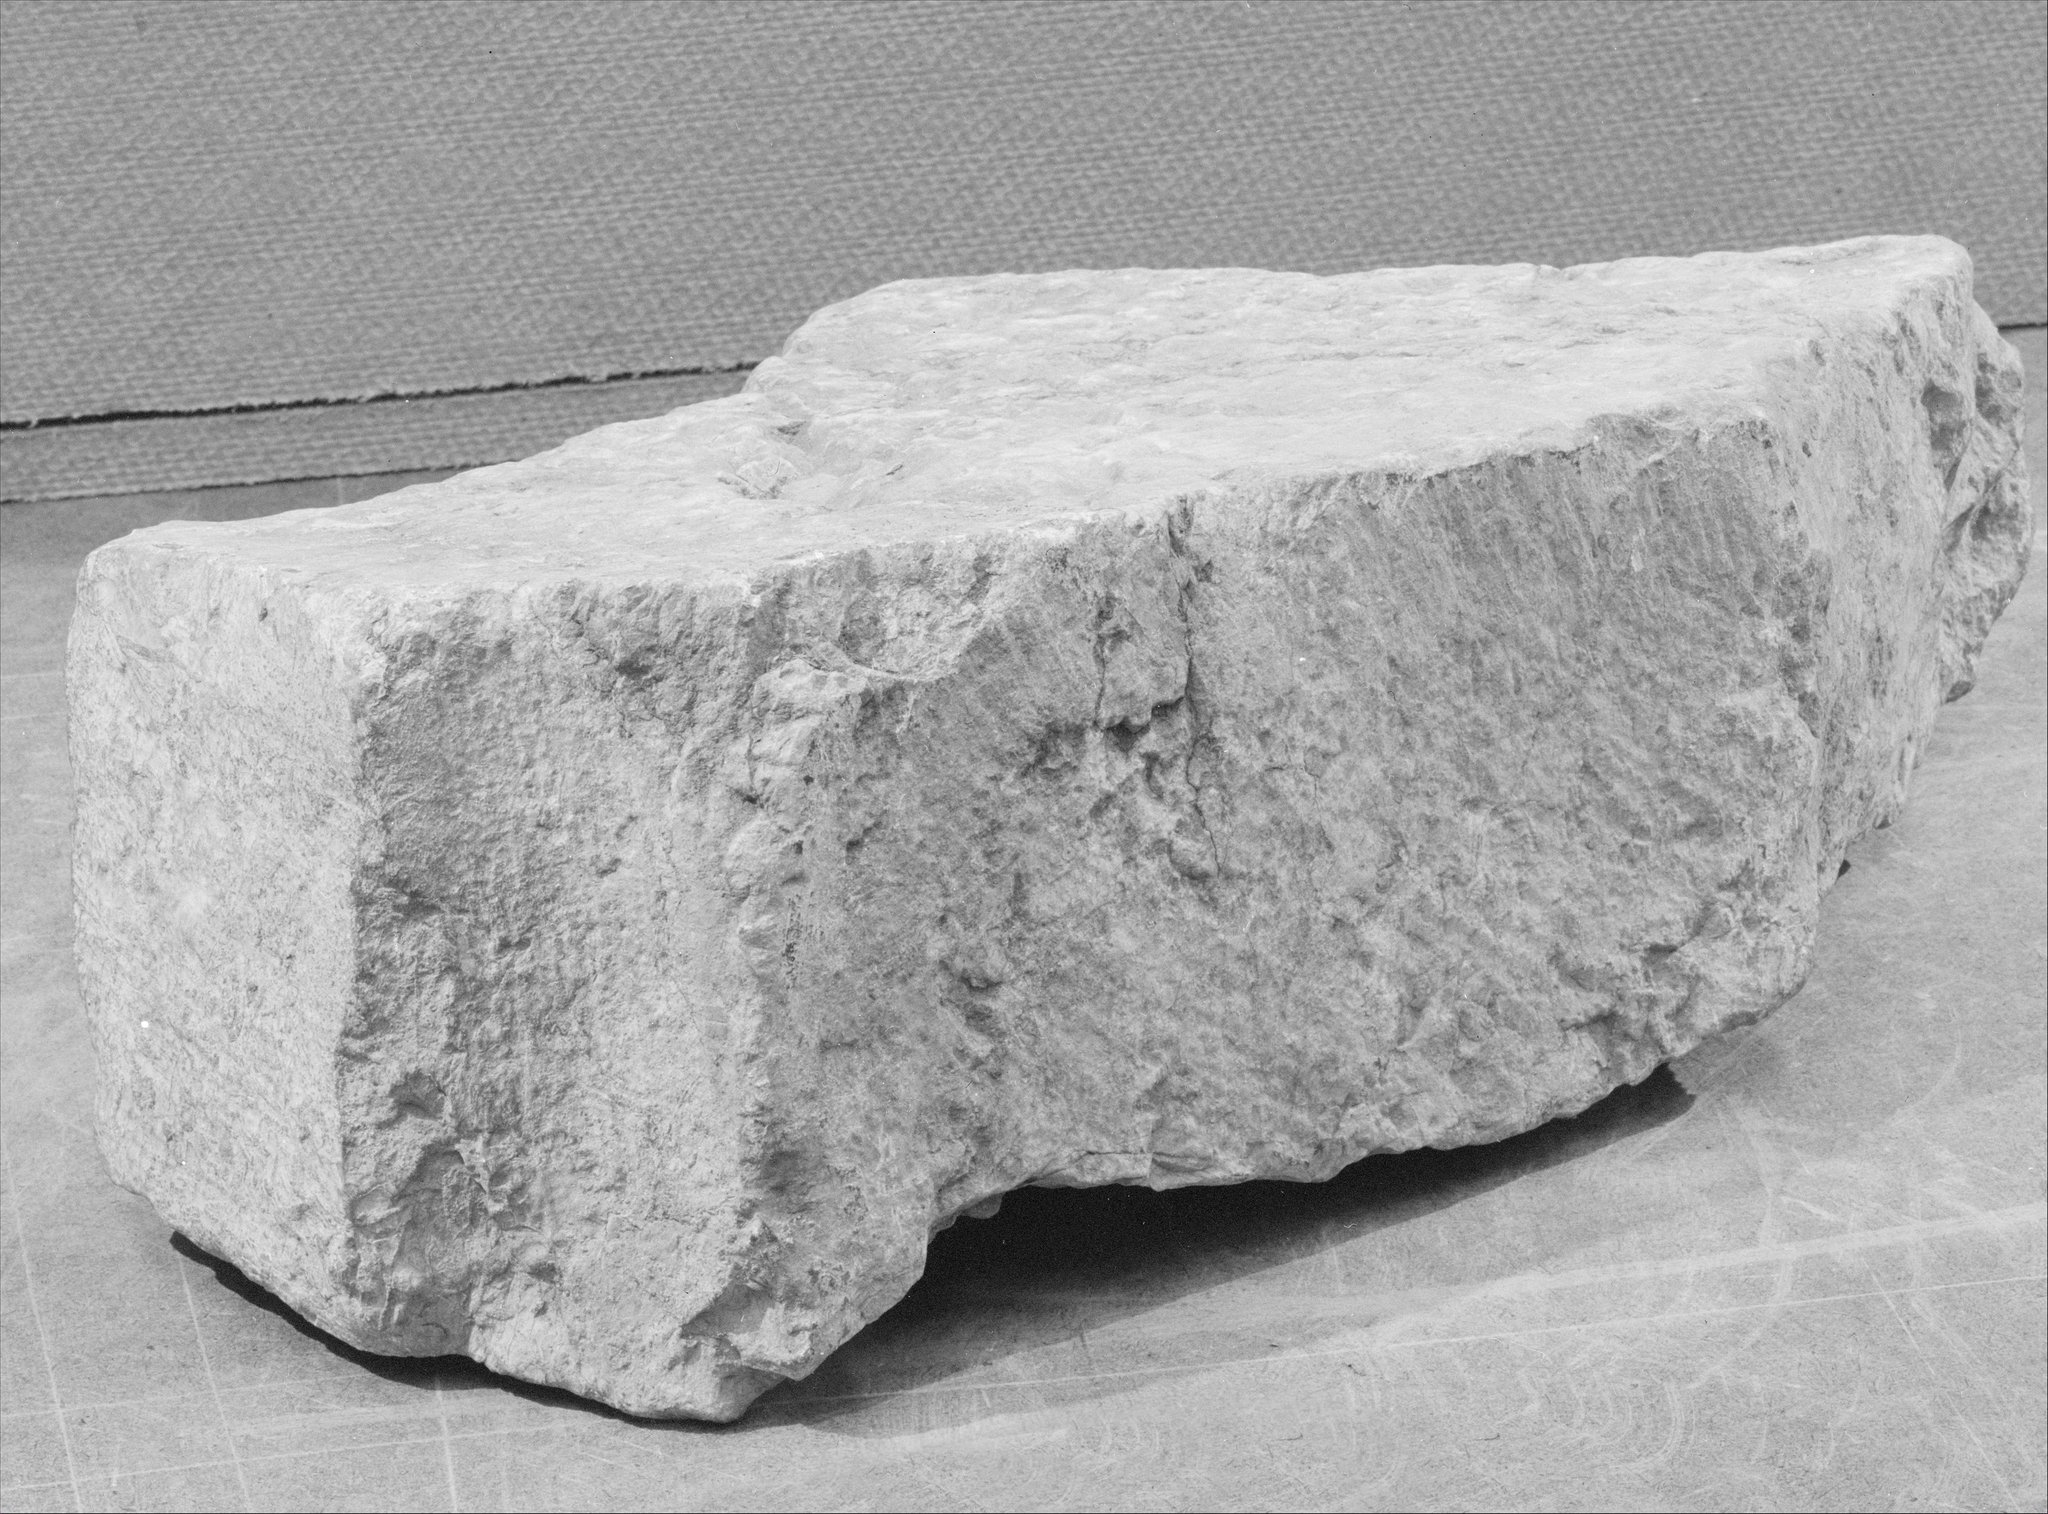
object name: block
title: Block Fragment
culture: french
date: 1130-1140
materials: stone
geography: france